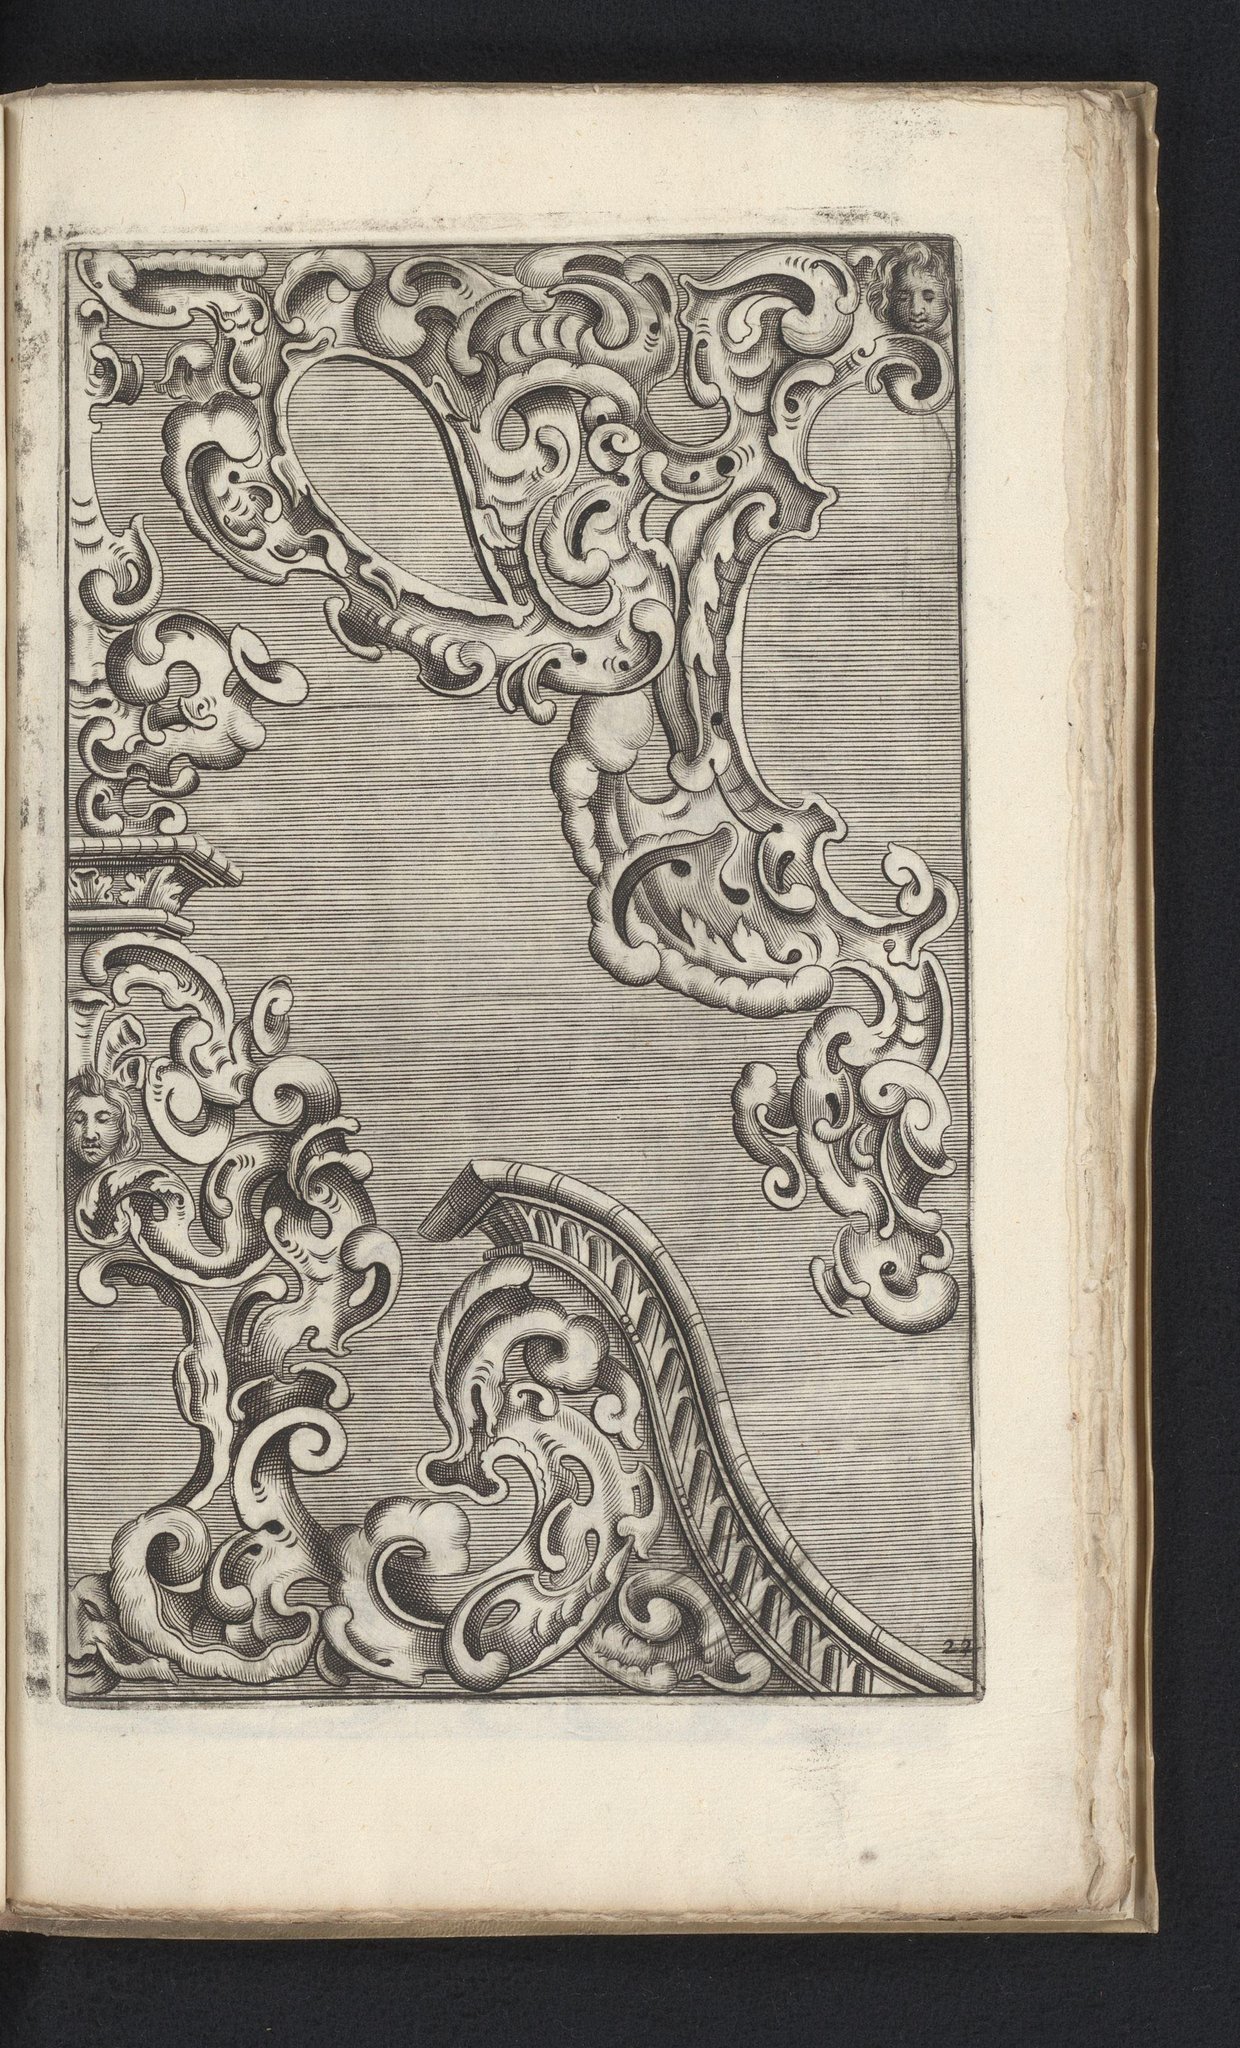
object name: ornament print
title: Ontwerpen voor altaren, tabernakels, epitafen, schouwen, sledes etc.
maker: Anonymous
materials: paper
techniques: engraving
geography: nuremberg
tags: auricular ornament, lobe style ~ ornament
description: Deze prent maakt deel uit van een album.